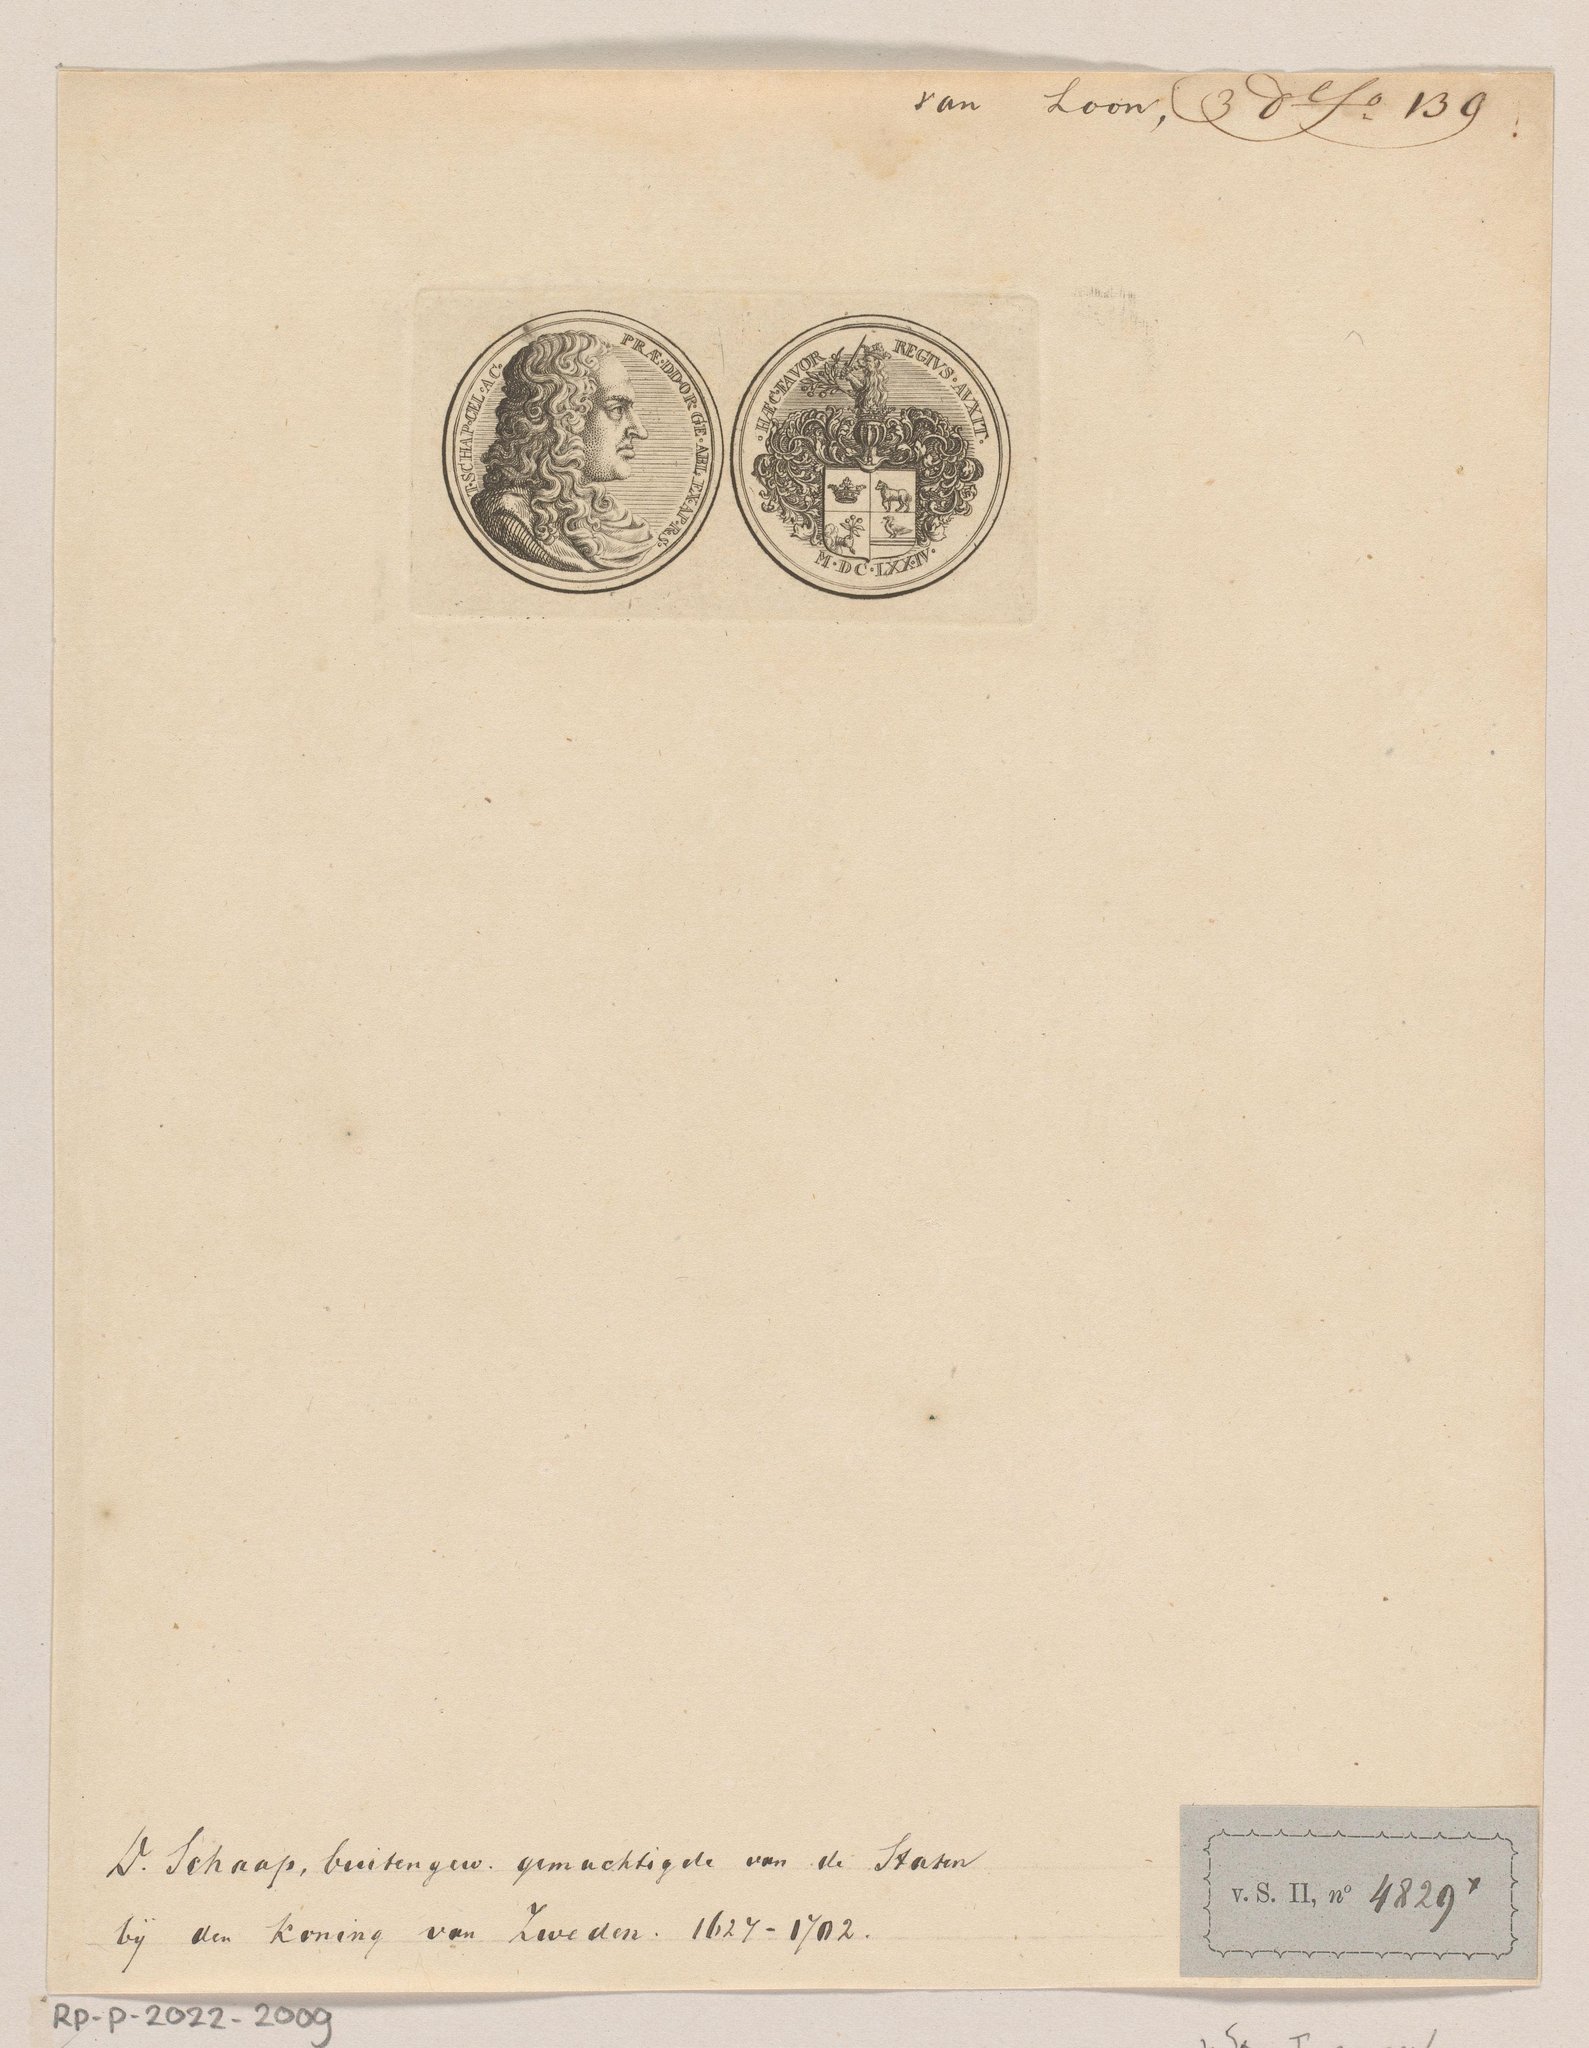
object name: print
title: Voor- en achterzijde van een penning met het portret van Dirck Schaep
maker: Anonymous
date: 1728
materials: paper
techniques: etching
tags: historical persons, diplomacy, diplomat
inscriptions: inscription: ‘van Loon, 3 def. (?) 139 :’, inscription: ‘D. Schaap, buitengew. gemachtigde van de Staten / bij den koning van Zweden. 1627-1702.’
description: Prent met tekst in boekdruk gebruikt in: Loon, Gerard van. Beschryving der Nederlandsche Historipenningen: (...). Den Haag: Christiaan van Lom et al., 1728, dl. 3, p. 139.